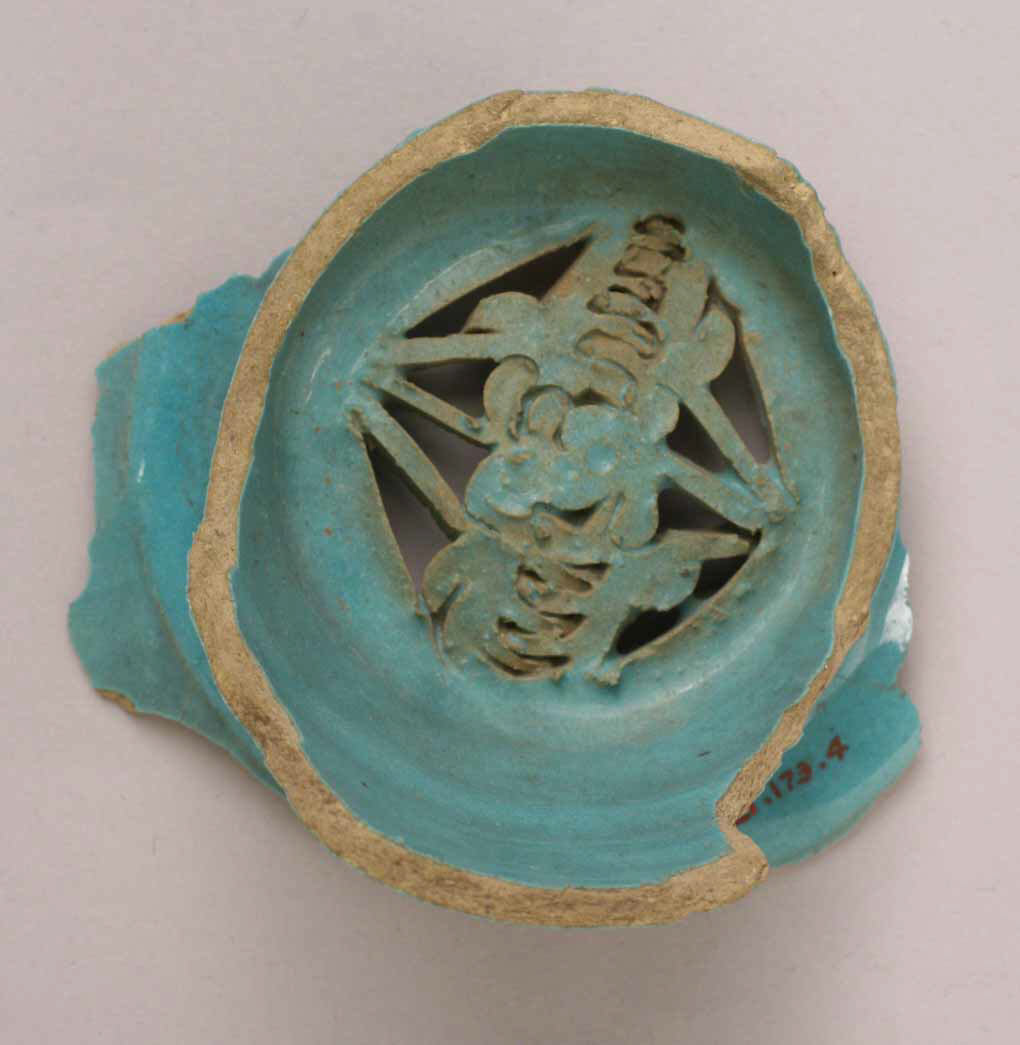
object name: water filter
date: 901-1200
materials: stonepaste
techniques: glazing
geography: egypt